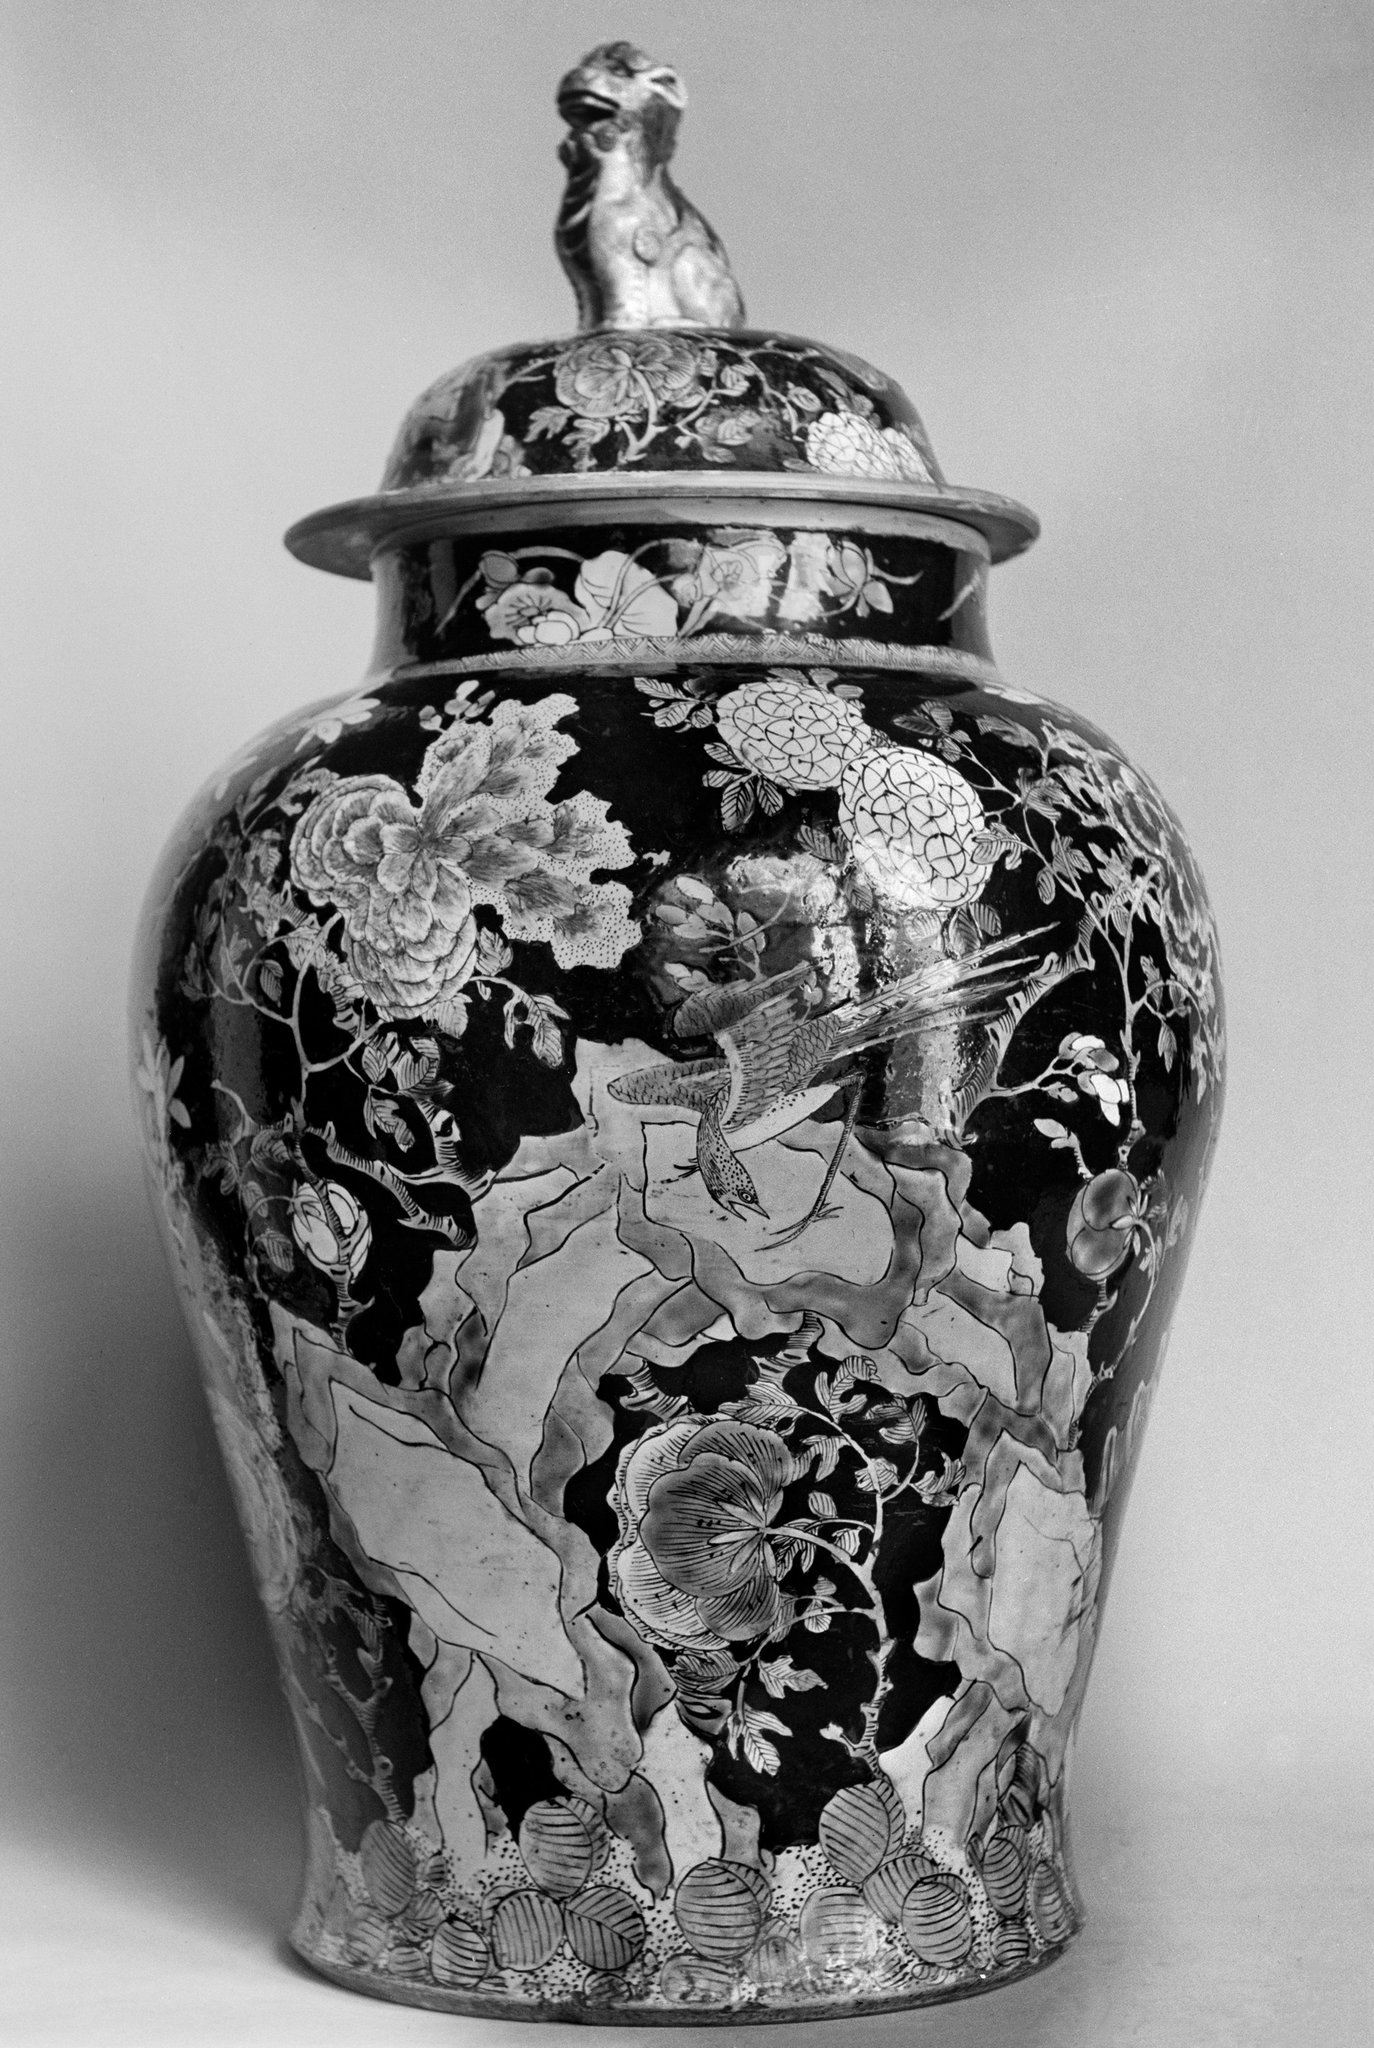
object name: covered jar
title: Covered jar with birds and flowers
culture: chinese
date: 1801-1900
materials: enamel, porcelain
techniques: painting, polychrome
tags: birds,flowers